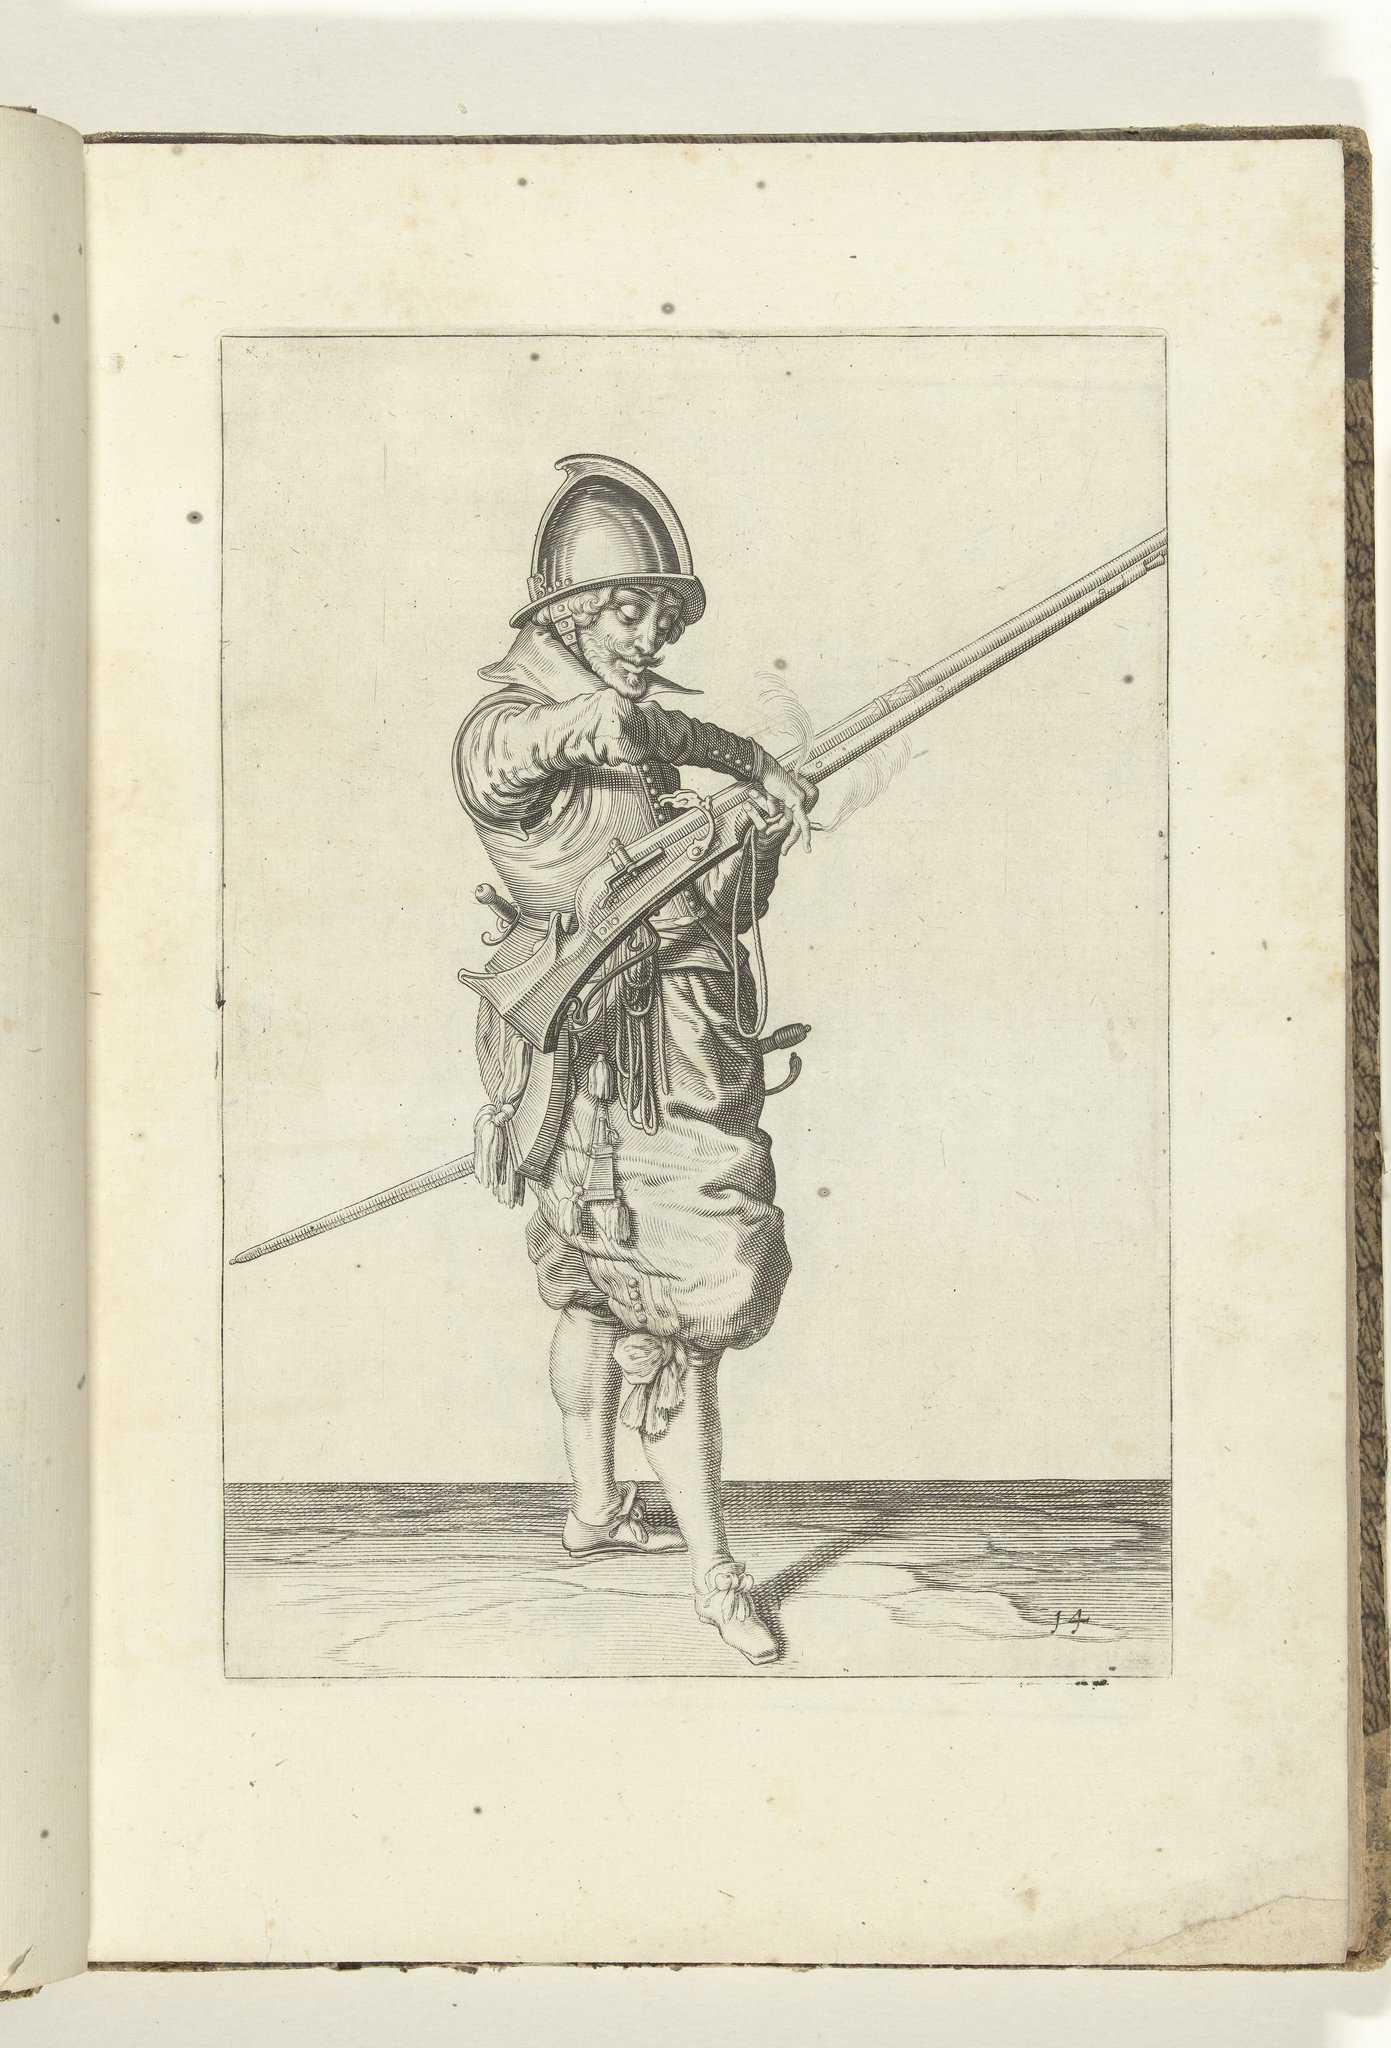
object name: print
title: Soldaat met een roer die zijn lont overbrengt van zijn rechter- naar zijn linkerhand (nr. 14), ca. 1600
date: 1597-1608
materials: paper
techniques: engraving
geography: amsterdam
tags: maurice (prince of orange), handling of weapons ~ military training, weapons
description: Een soldaat, ten voeten uit, naar rechts, die een roer (een bepaald type vuurwapen) met zijn linkerhand vasthoudt (nr. 14), ca. 1600. De brandende lont in zijn rechterhand brengt hij over naar zijn linkerhand. Plaat 14 in de instructies voor het hanteren van de roer: Brief enseignement, sur la representation des figures, du droit maniement de l'Harquebuse. Onderdeel van de illustraties in een Franse editie van J. de Gheyns Wapenhandelinghe: J. de Gheyn, Maniement d'armes, d'arquebuses, mousquetz et piques : en conformité de l'ordre de Mour le Prince Maurice, Prince d'Orange, Amsterdam 1608. Krijgswezen rond 1600.